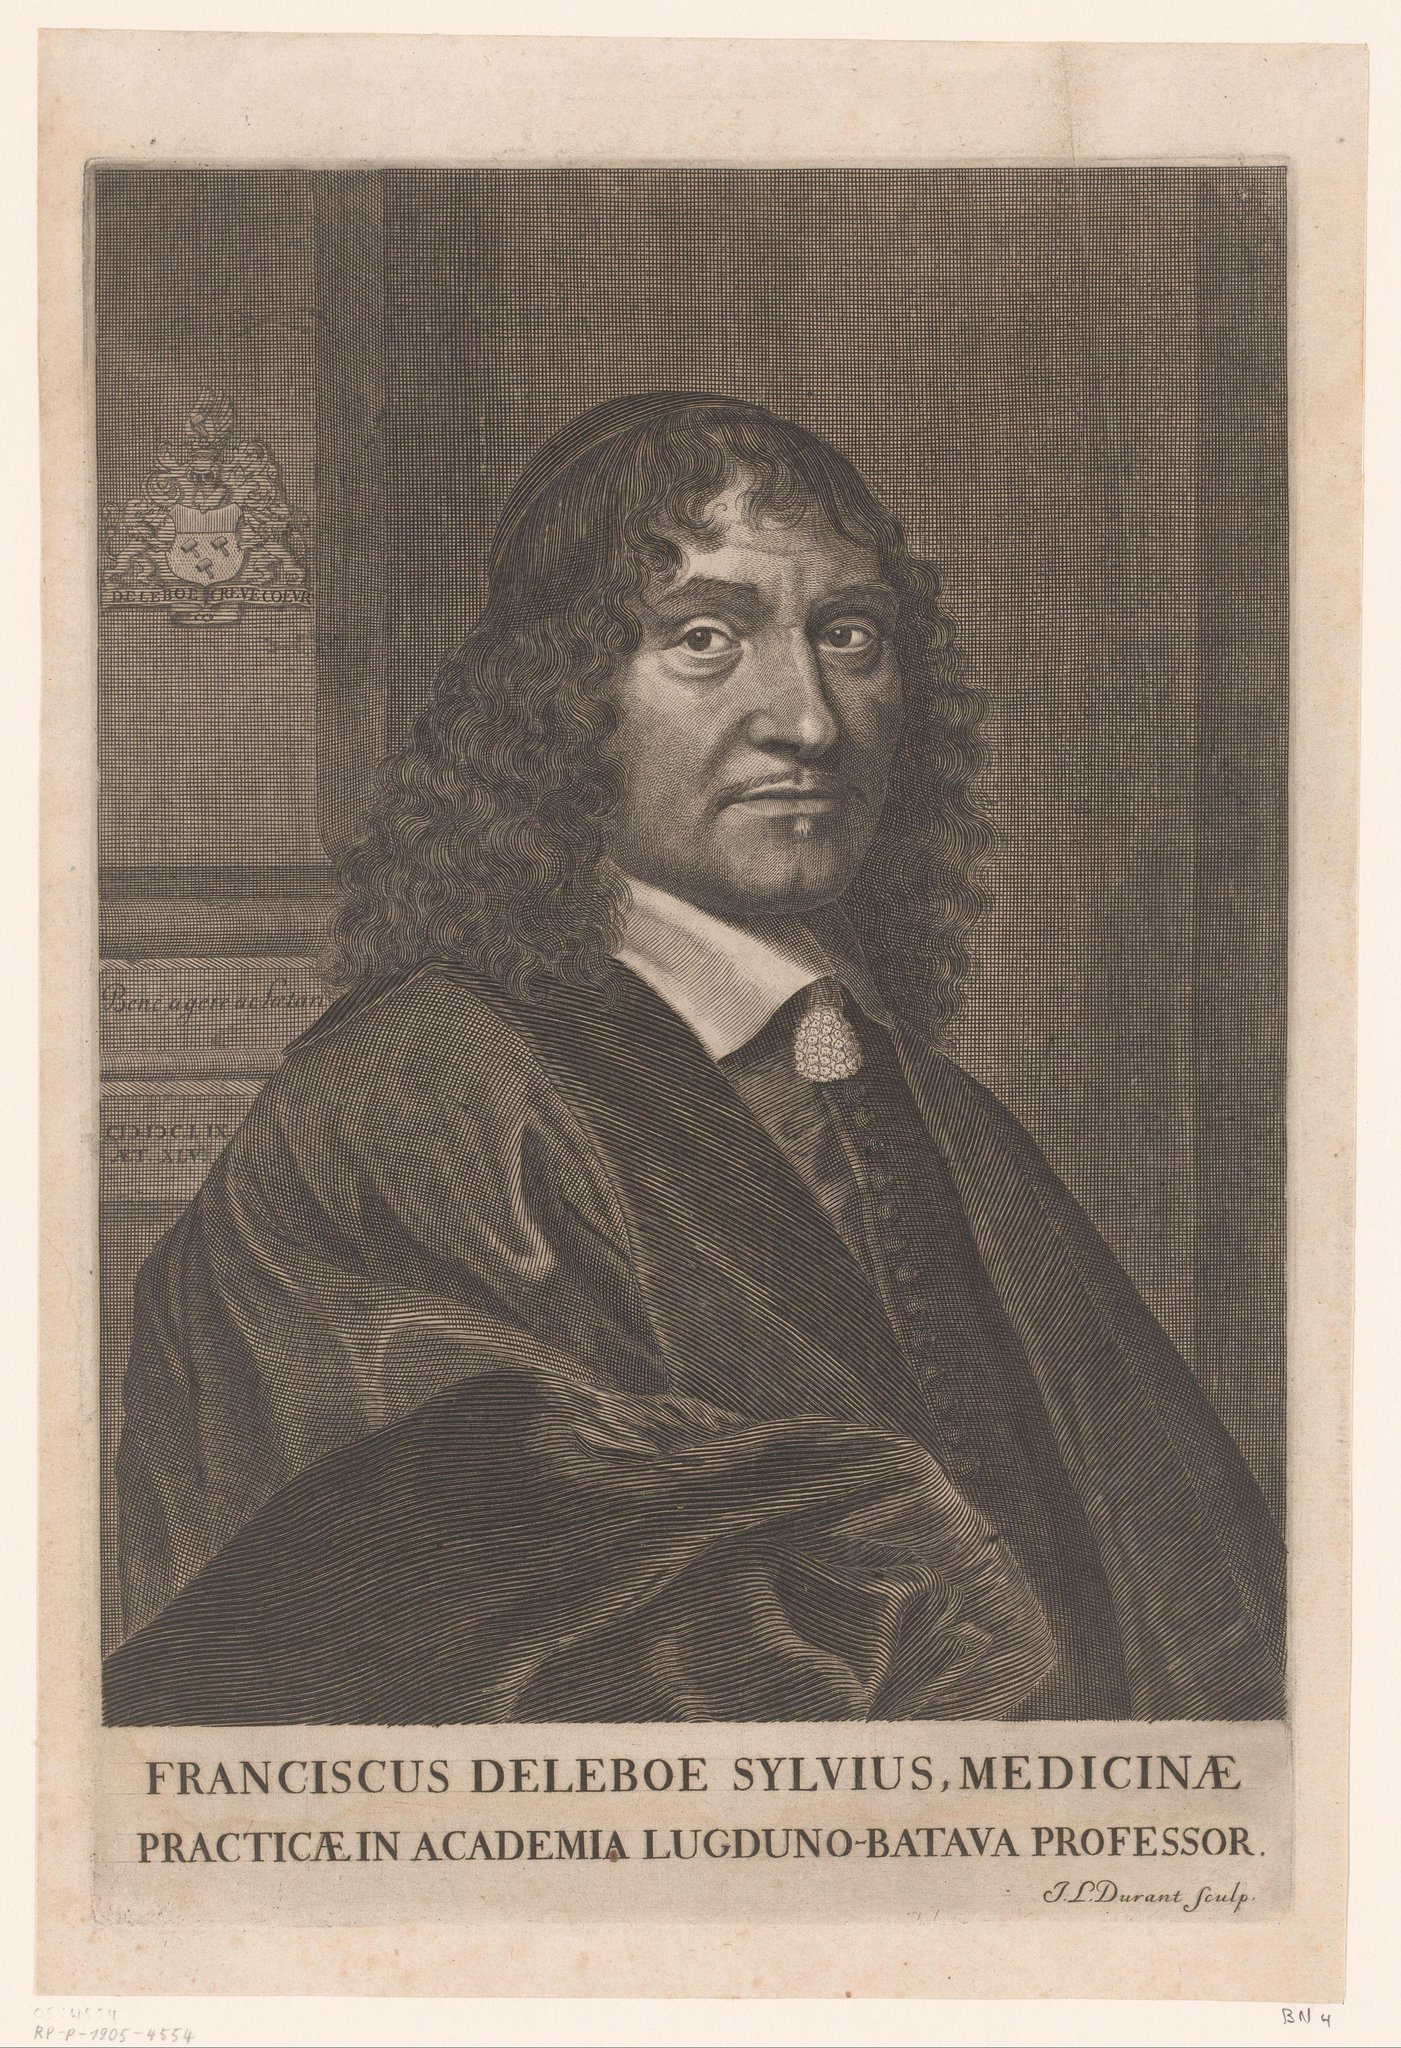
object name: print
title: Portret van Franciscus de le Boë Sylvius op 45-jarige leeftijd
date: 1659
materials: paper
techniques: engraving, intaglio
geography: france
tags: historical persons, physician, doctor, armorial bearing, heraldry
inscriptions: collector's mark: Lugt 2228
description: Prent uit: Sylvius, Franciscus de le Boë. Medicinae practicae in academia Lugduno-Batava professoris, Opera medica (...). Genève: Samuelem de Tournes, ca. 1659.